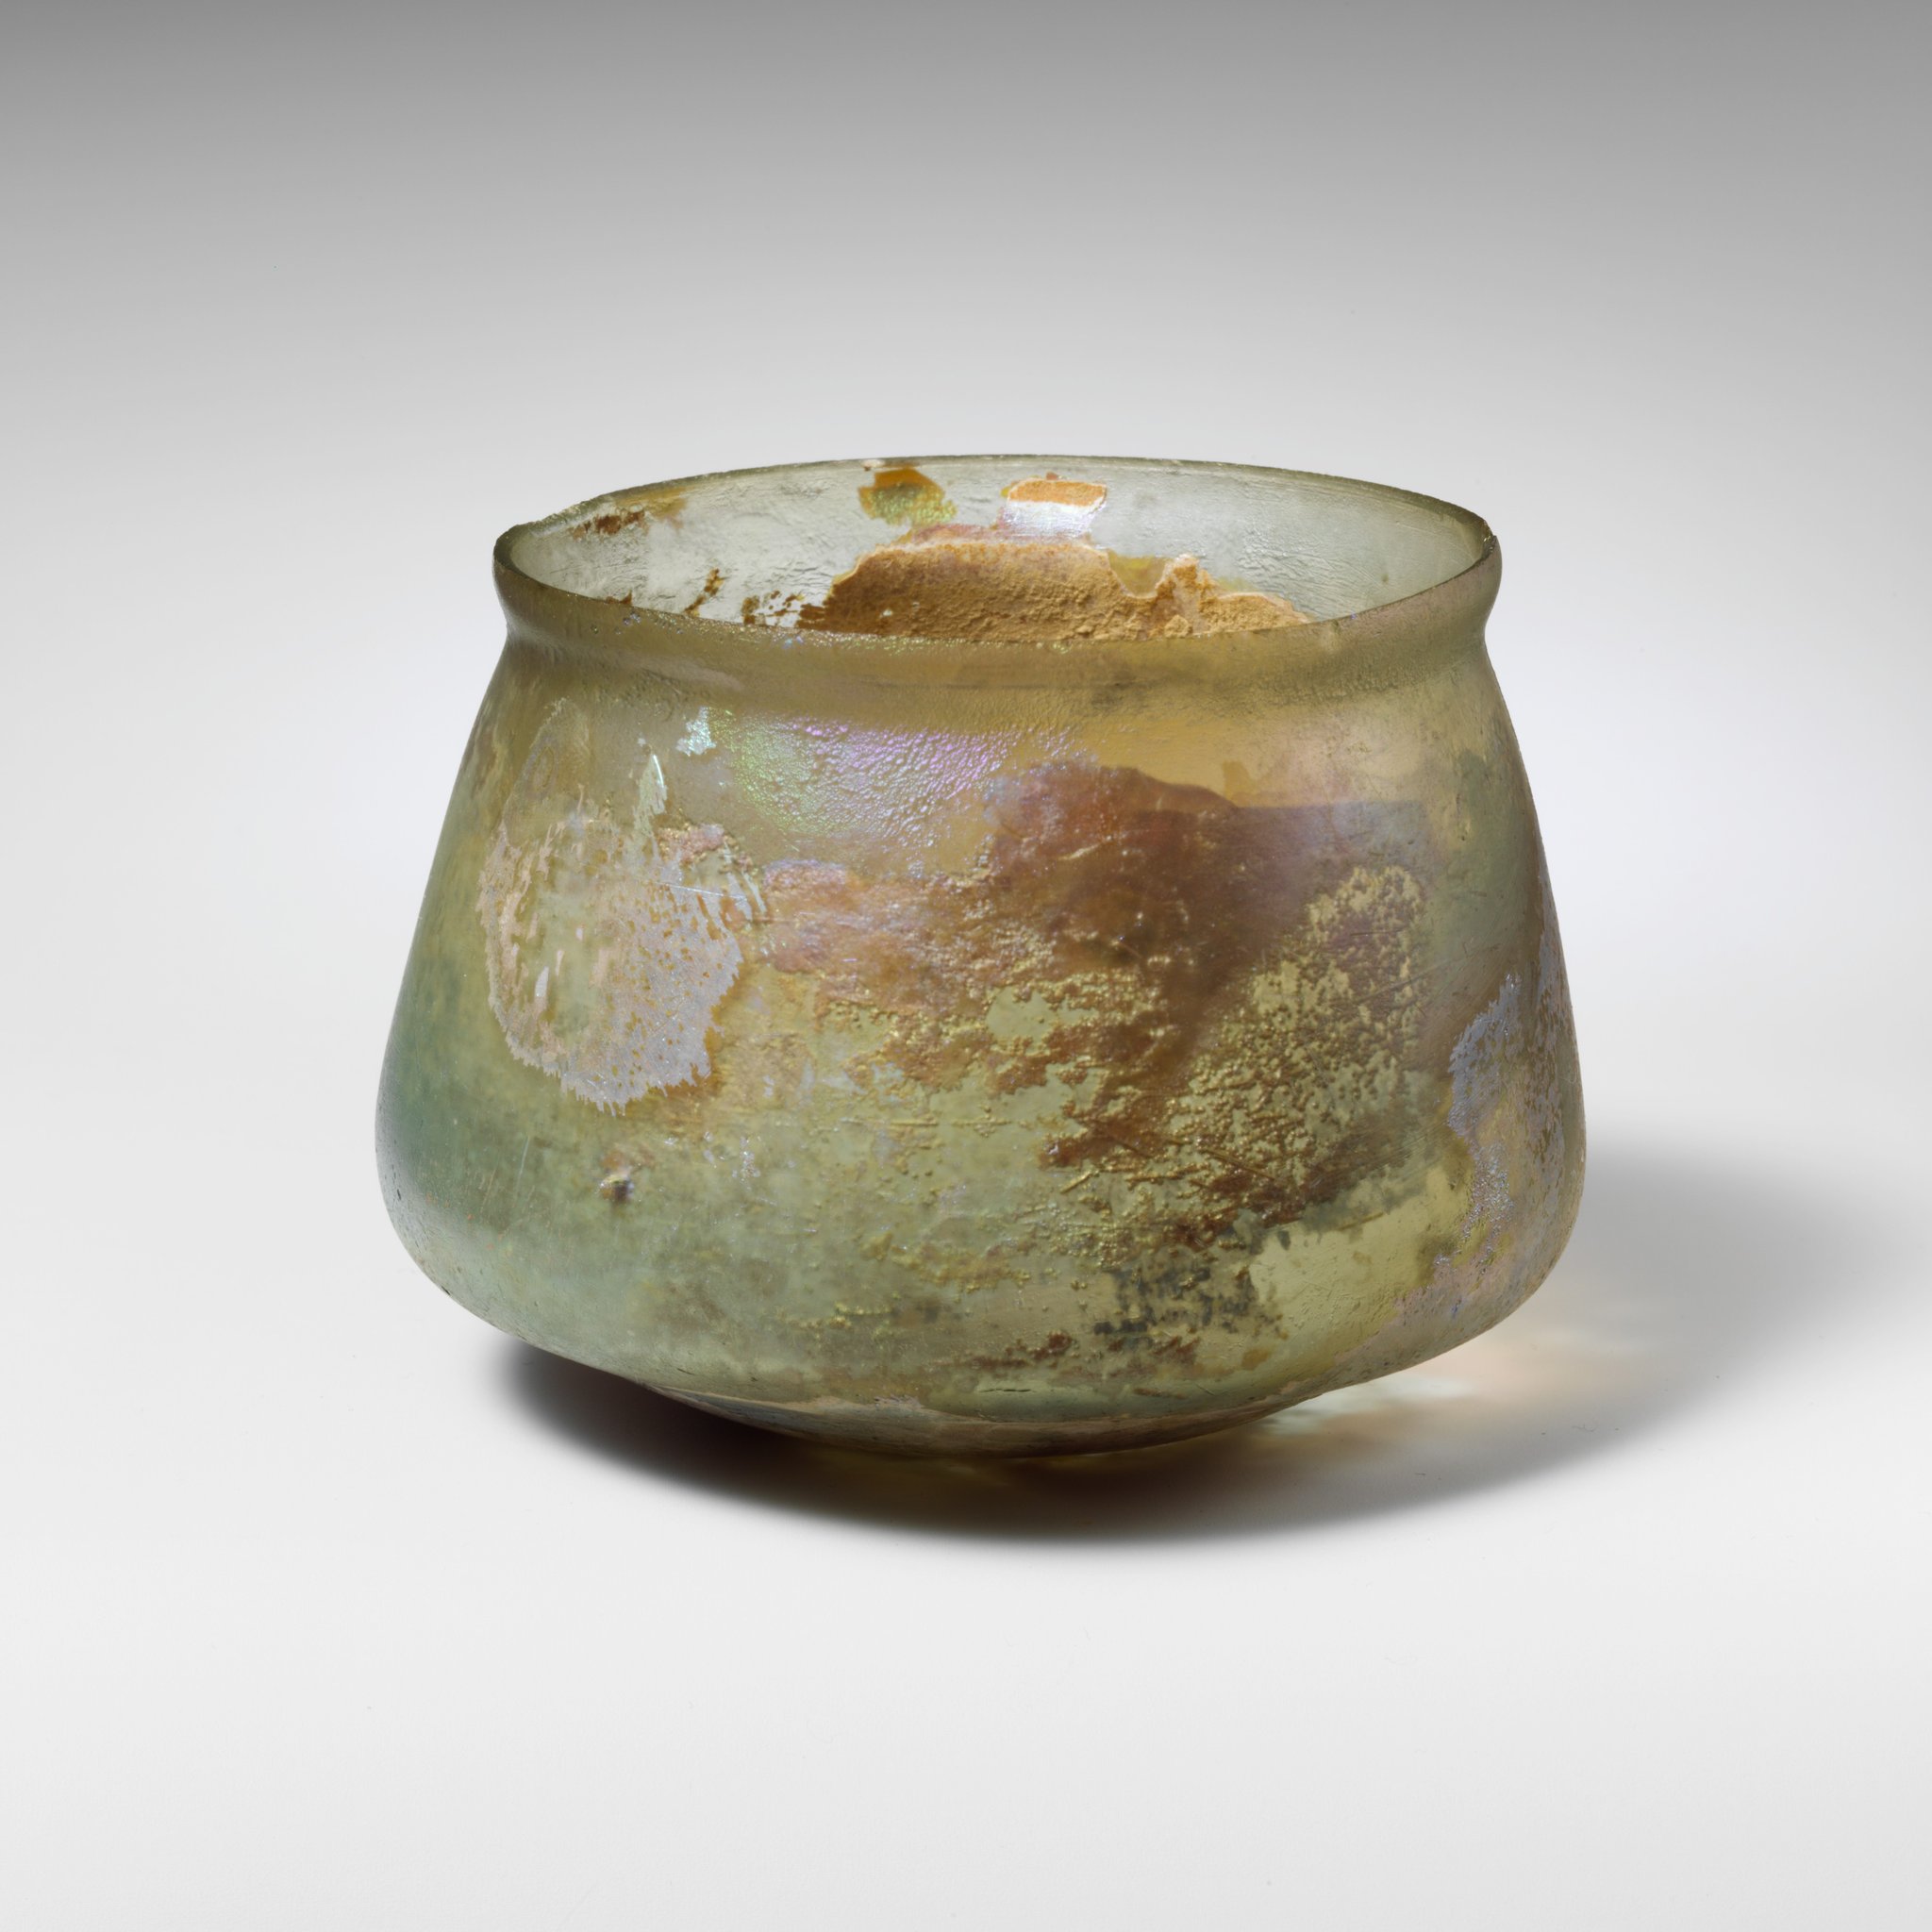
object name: cup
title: Glass cup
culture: roman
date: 101-300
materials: glass